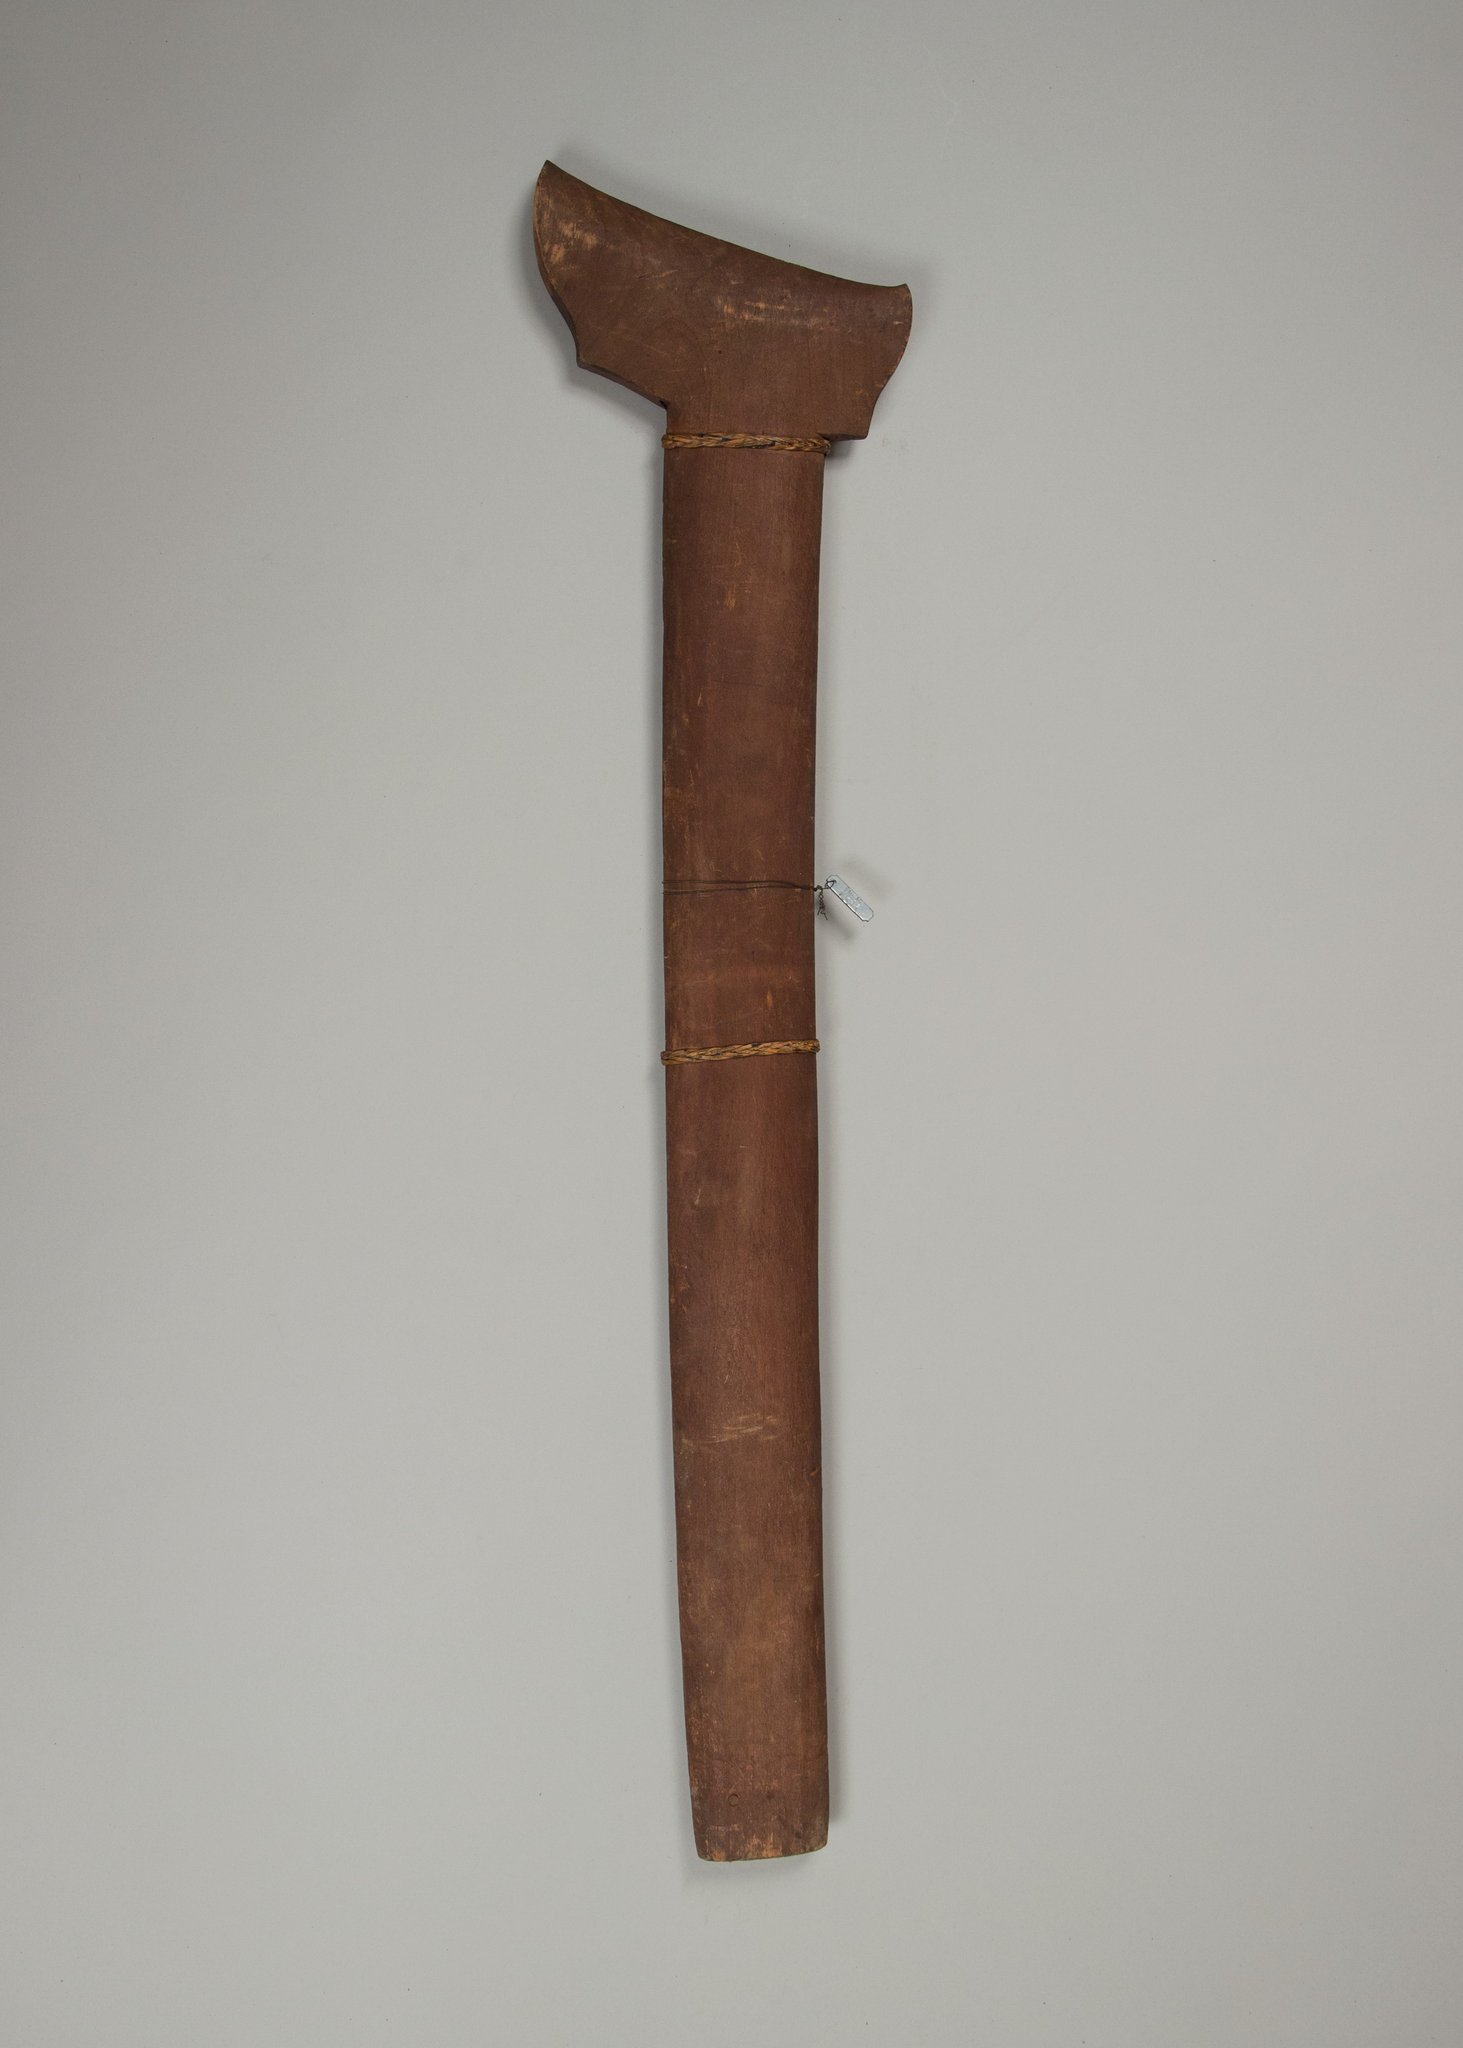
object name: kris with sheath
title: Sheath for a Kris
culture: philippine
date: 1701-1900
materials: cord, wood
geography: philippines